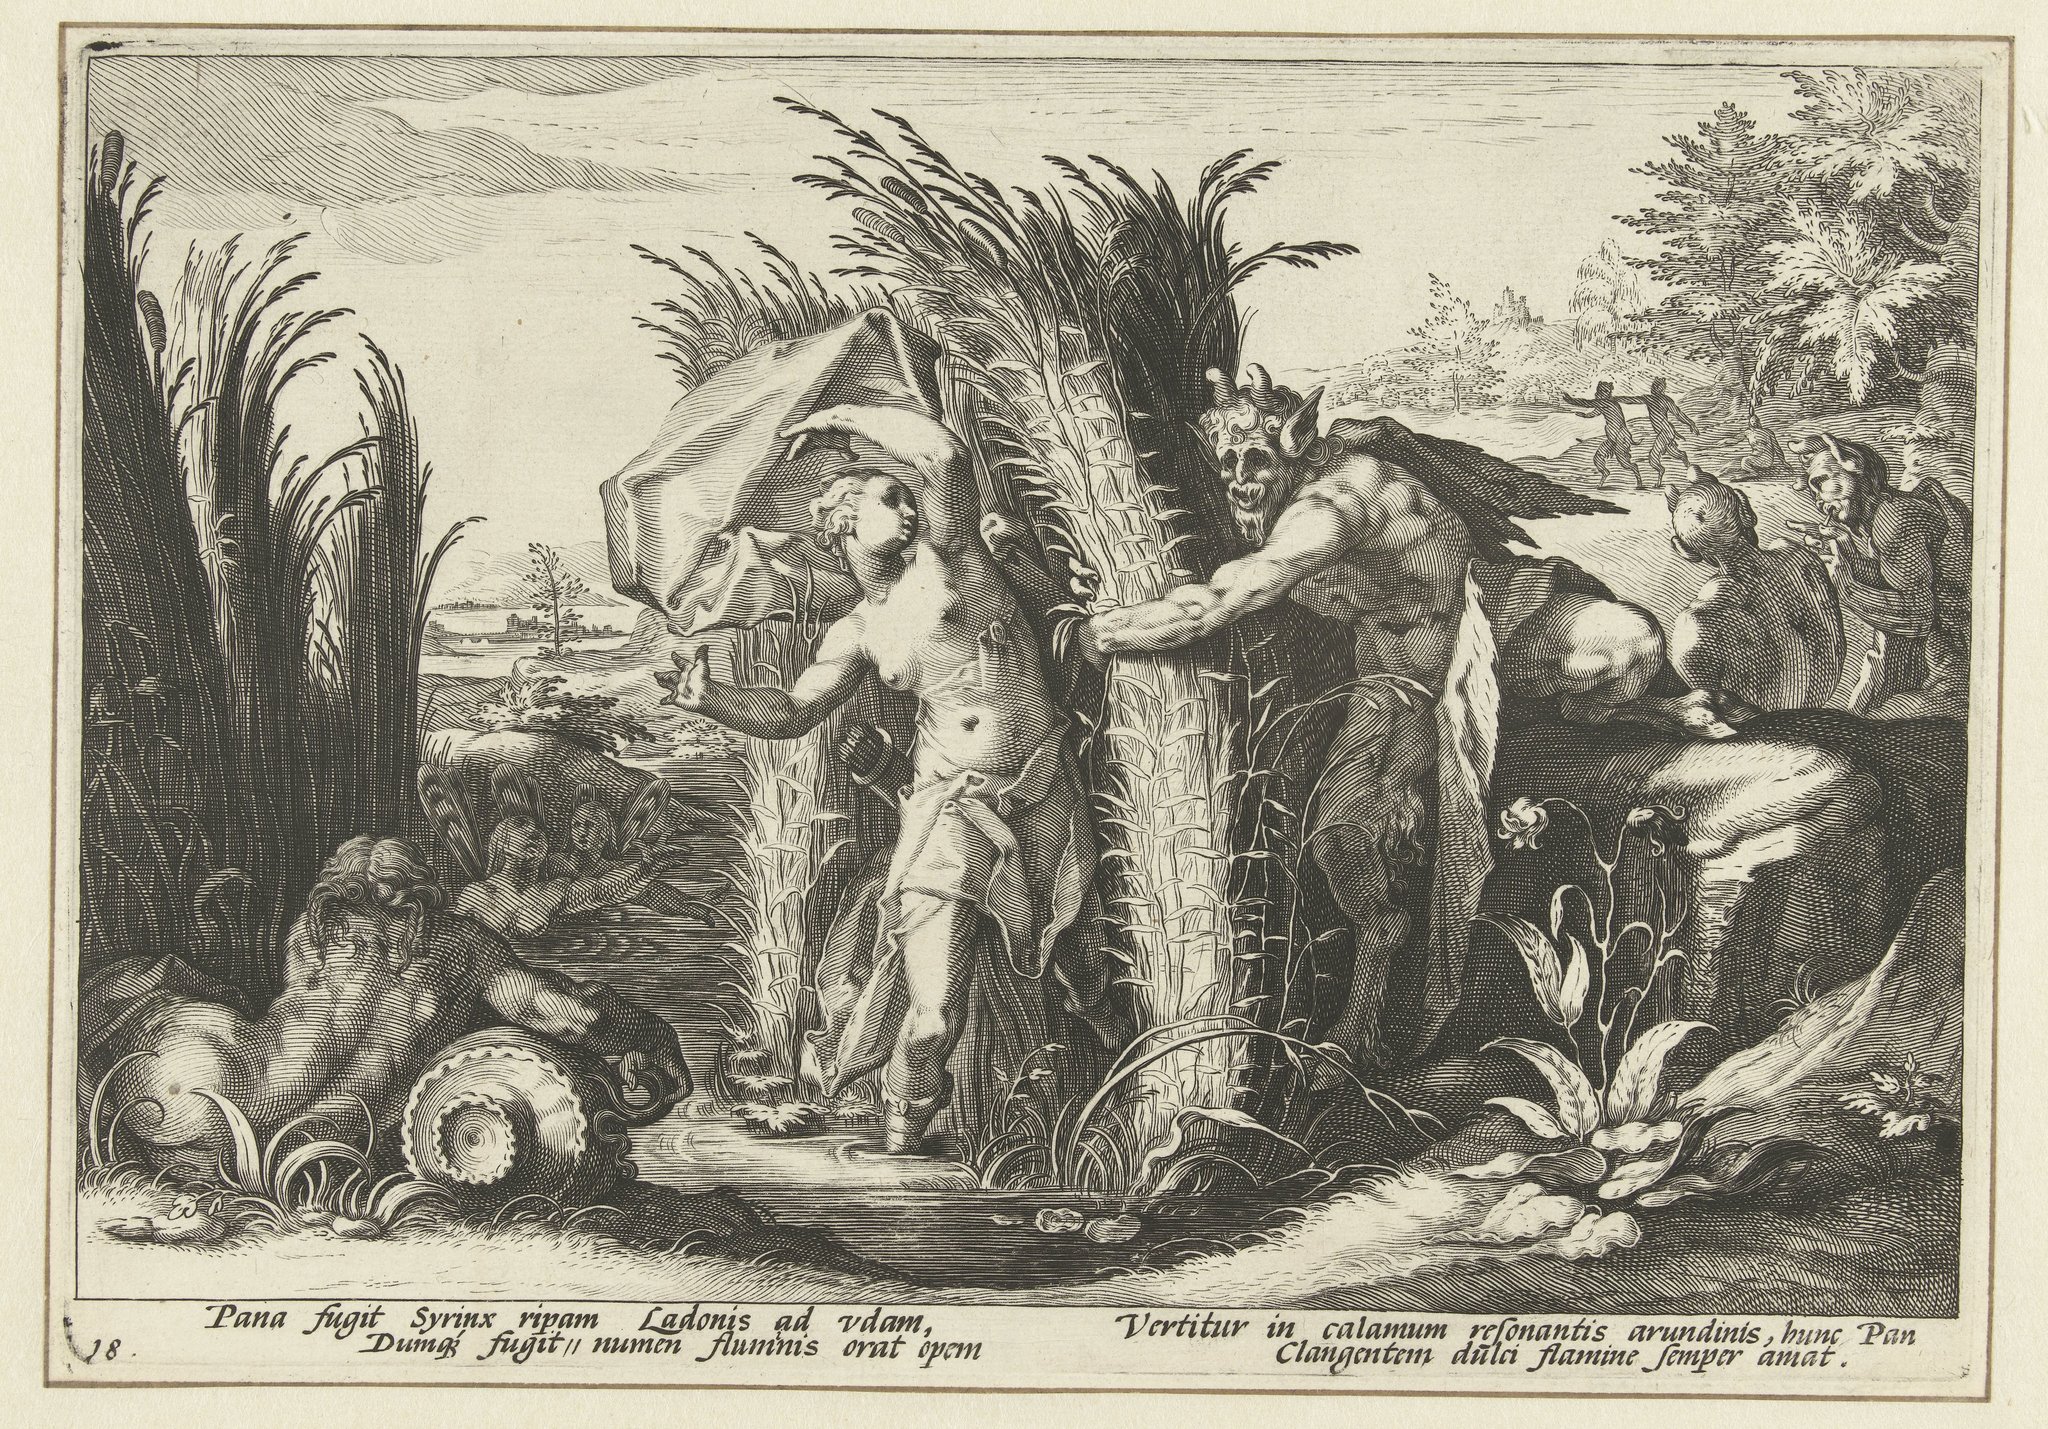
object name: print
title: Ovidius' Metamorfosen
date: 1589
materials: paper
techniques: engraving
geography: haarlem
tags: (story of) pan, single named nymphs (with name), syrinx changed into a reed: while fleeing from pan, the nymph syrinx is changed into reed by her sisters, the naiads (ovid, metamorphoses i 705)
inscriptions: caption: ‘Pana fugit....semper amat.’, number: ‘18.’, collector's mark: Lugt 2228a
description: De god Pan achtervolgt de nimf Syrinx. Zij kan ternauwernood aan hem ontkomen door aan de oever van de rivier de Ladon in riet veranderd te worden. Onder de voorstelling twee keer twee regels Latijnse tekst. Deze prent is onderdeel van een serie van 52 prenten die verhalen uit Ovidius' Metamorfosen verbeelden. Deze serie valt uiteen in drie genummerde reeksen: twee van 20 prenten en één van 12 prenten. Deze prent behoort tot de eerste reeks.